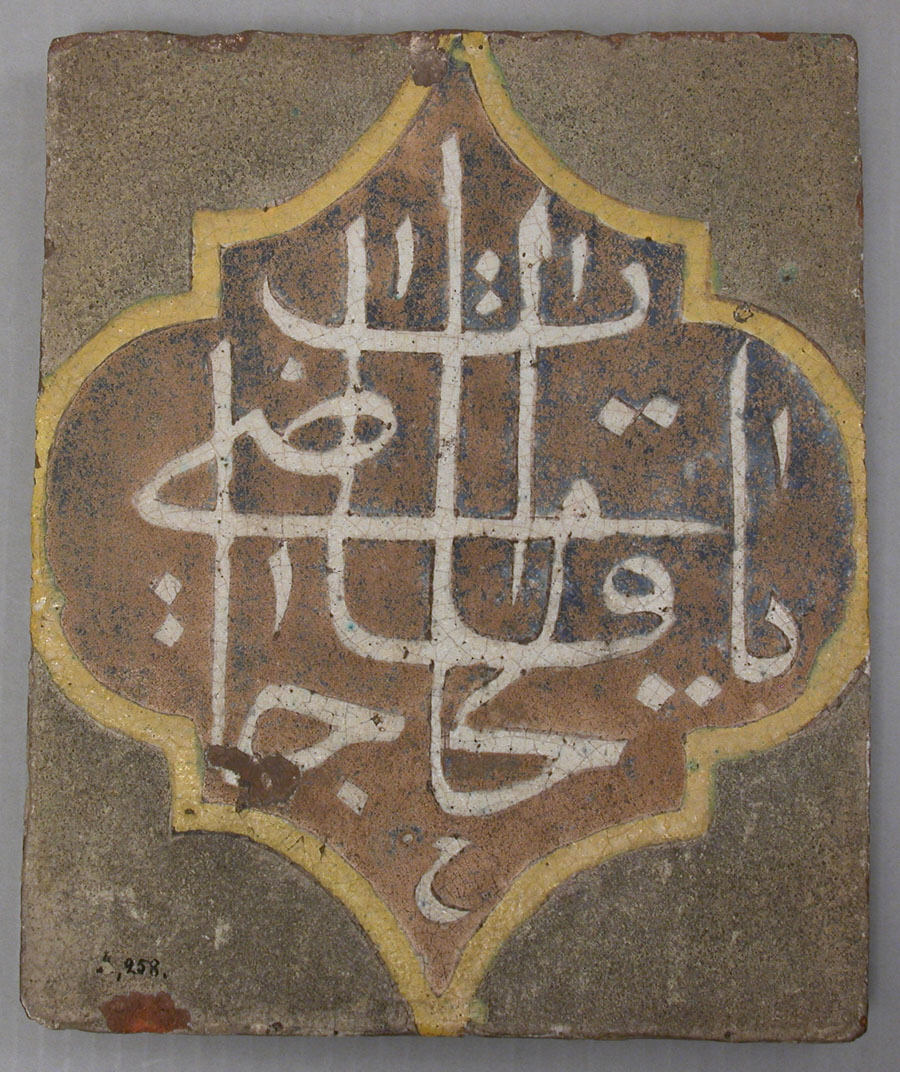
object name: tile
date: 1601-1700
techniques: glazing, painting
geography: iran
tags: calligraphy